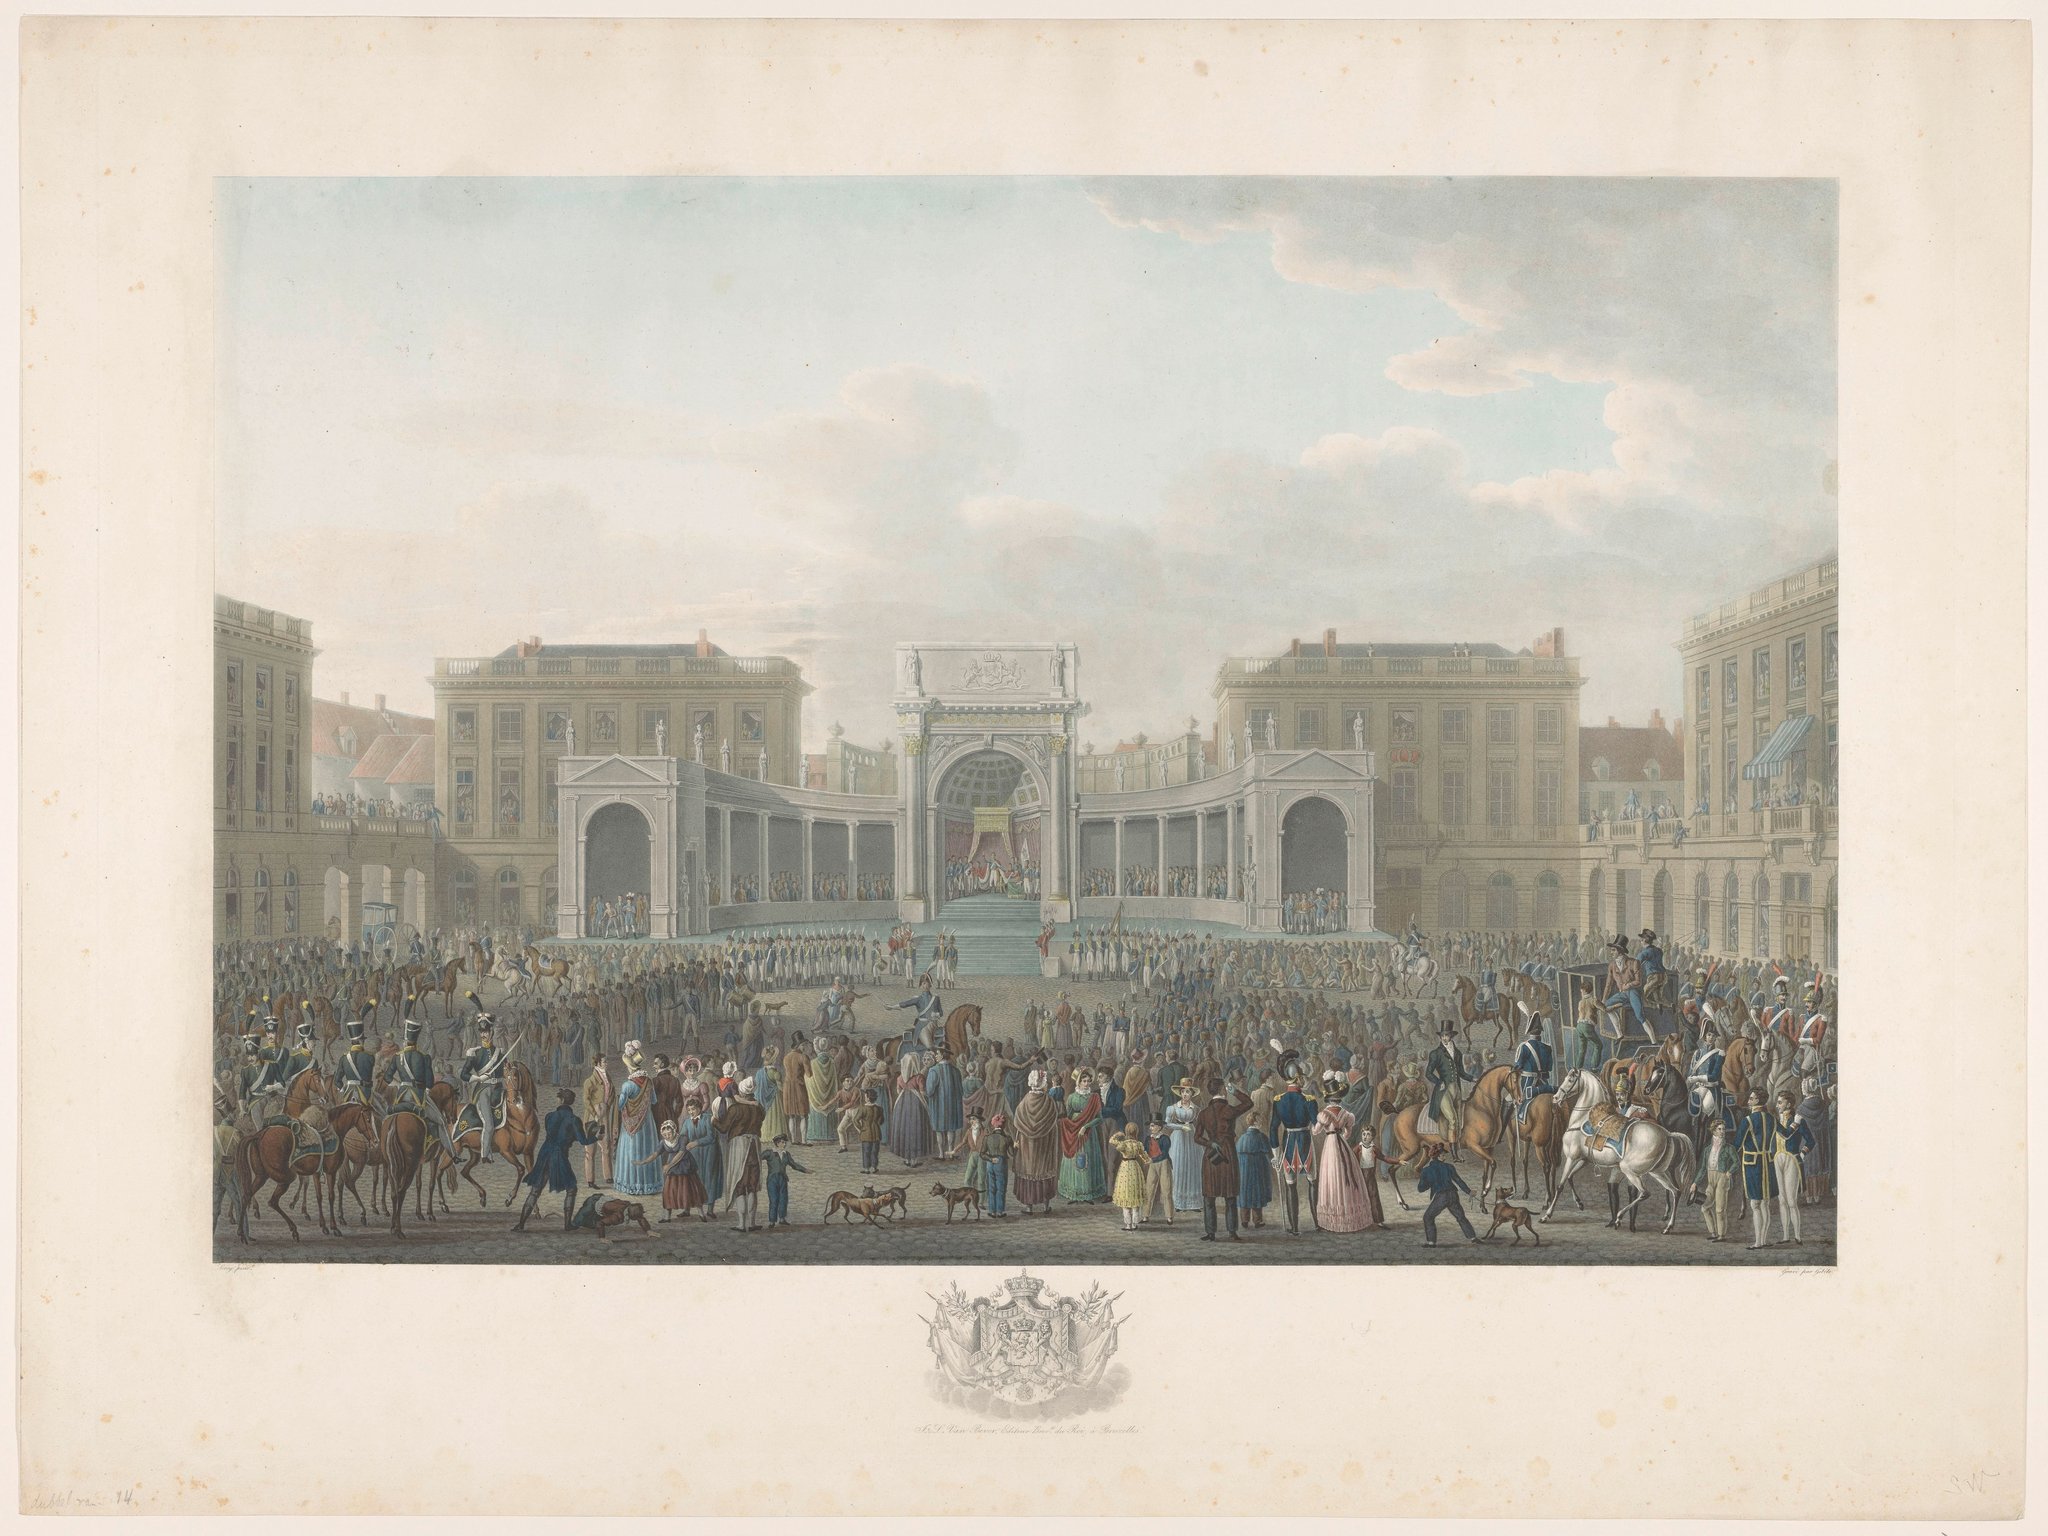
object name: print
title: Twaalf platen van de aankomst en inhuldiging van Willem I in Brussel en de slagen bij Quatre-Bras en Waterloo in 1815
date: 1825-1826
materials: paper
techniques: aquatint, etching, hand coloring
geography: brussels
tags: the hague, berlin, william i of the netherlands, new ruler taking the oath, brussels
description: Inhuldiging van koning Willem I te Brussel op 21 september 1815. Staande op een platform in de open lucht legt de koning ten overstaan van het publiek de eed af. Onderaan de titels in het Nederlands en Frans gescheiden door het wapen van koning Willem I. Onderdeel van een serie platen van de aankomst en inhuldiging van Willem I in Brussel.